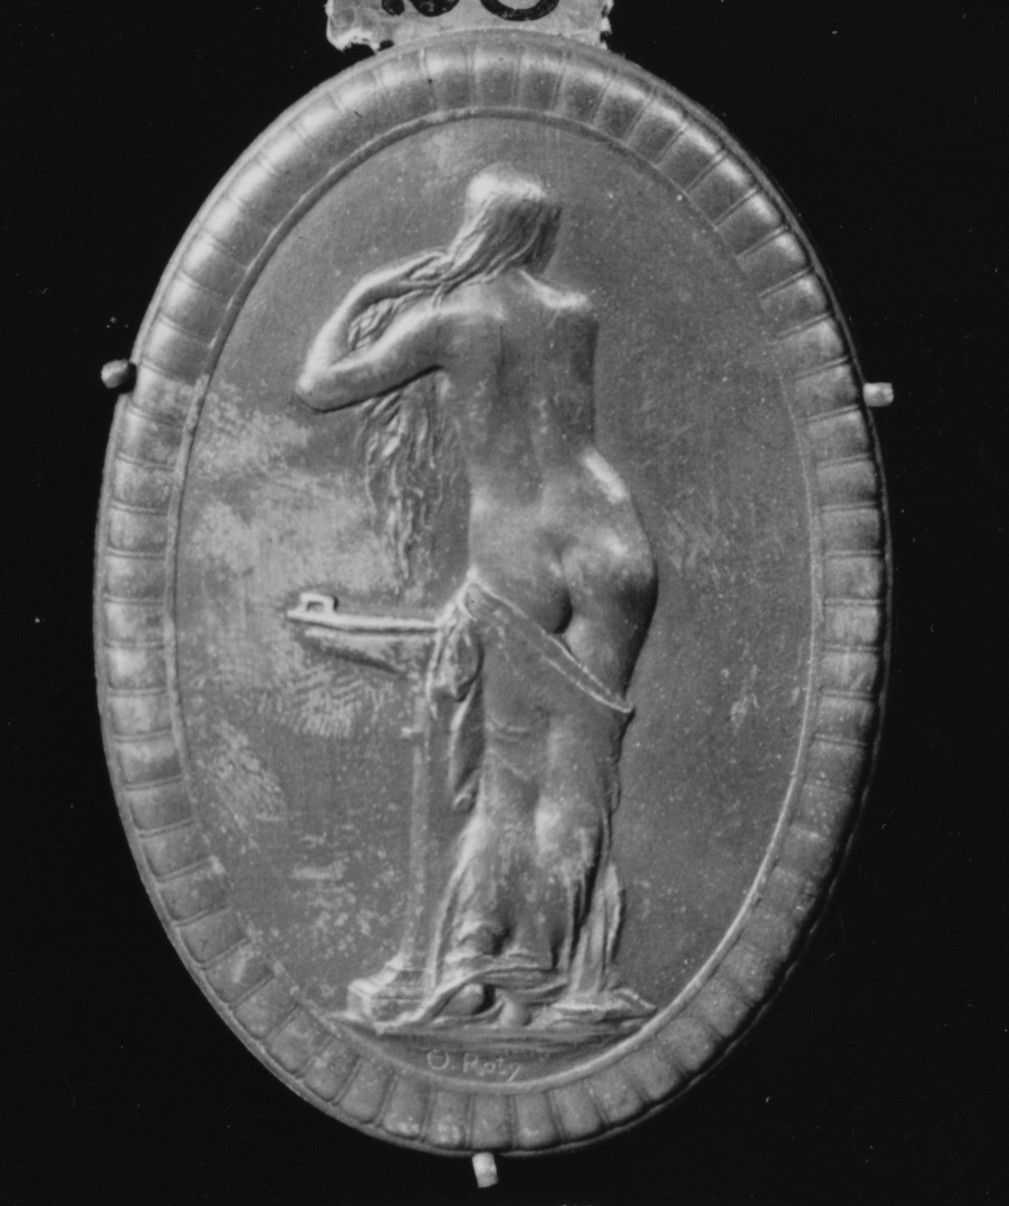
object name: medal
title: Young Greek woman making her toilet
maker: louis-oscar roty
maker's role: artist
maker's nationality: french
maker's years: 1846-1911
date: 1801-1900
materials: silver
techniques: casting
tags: female nudes,bathing